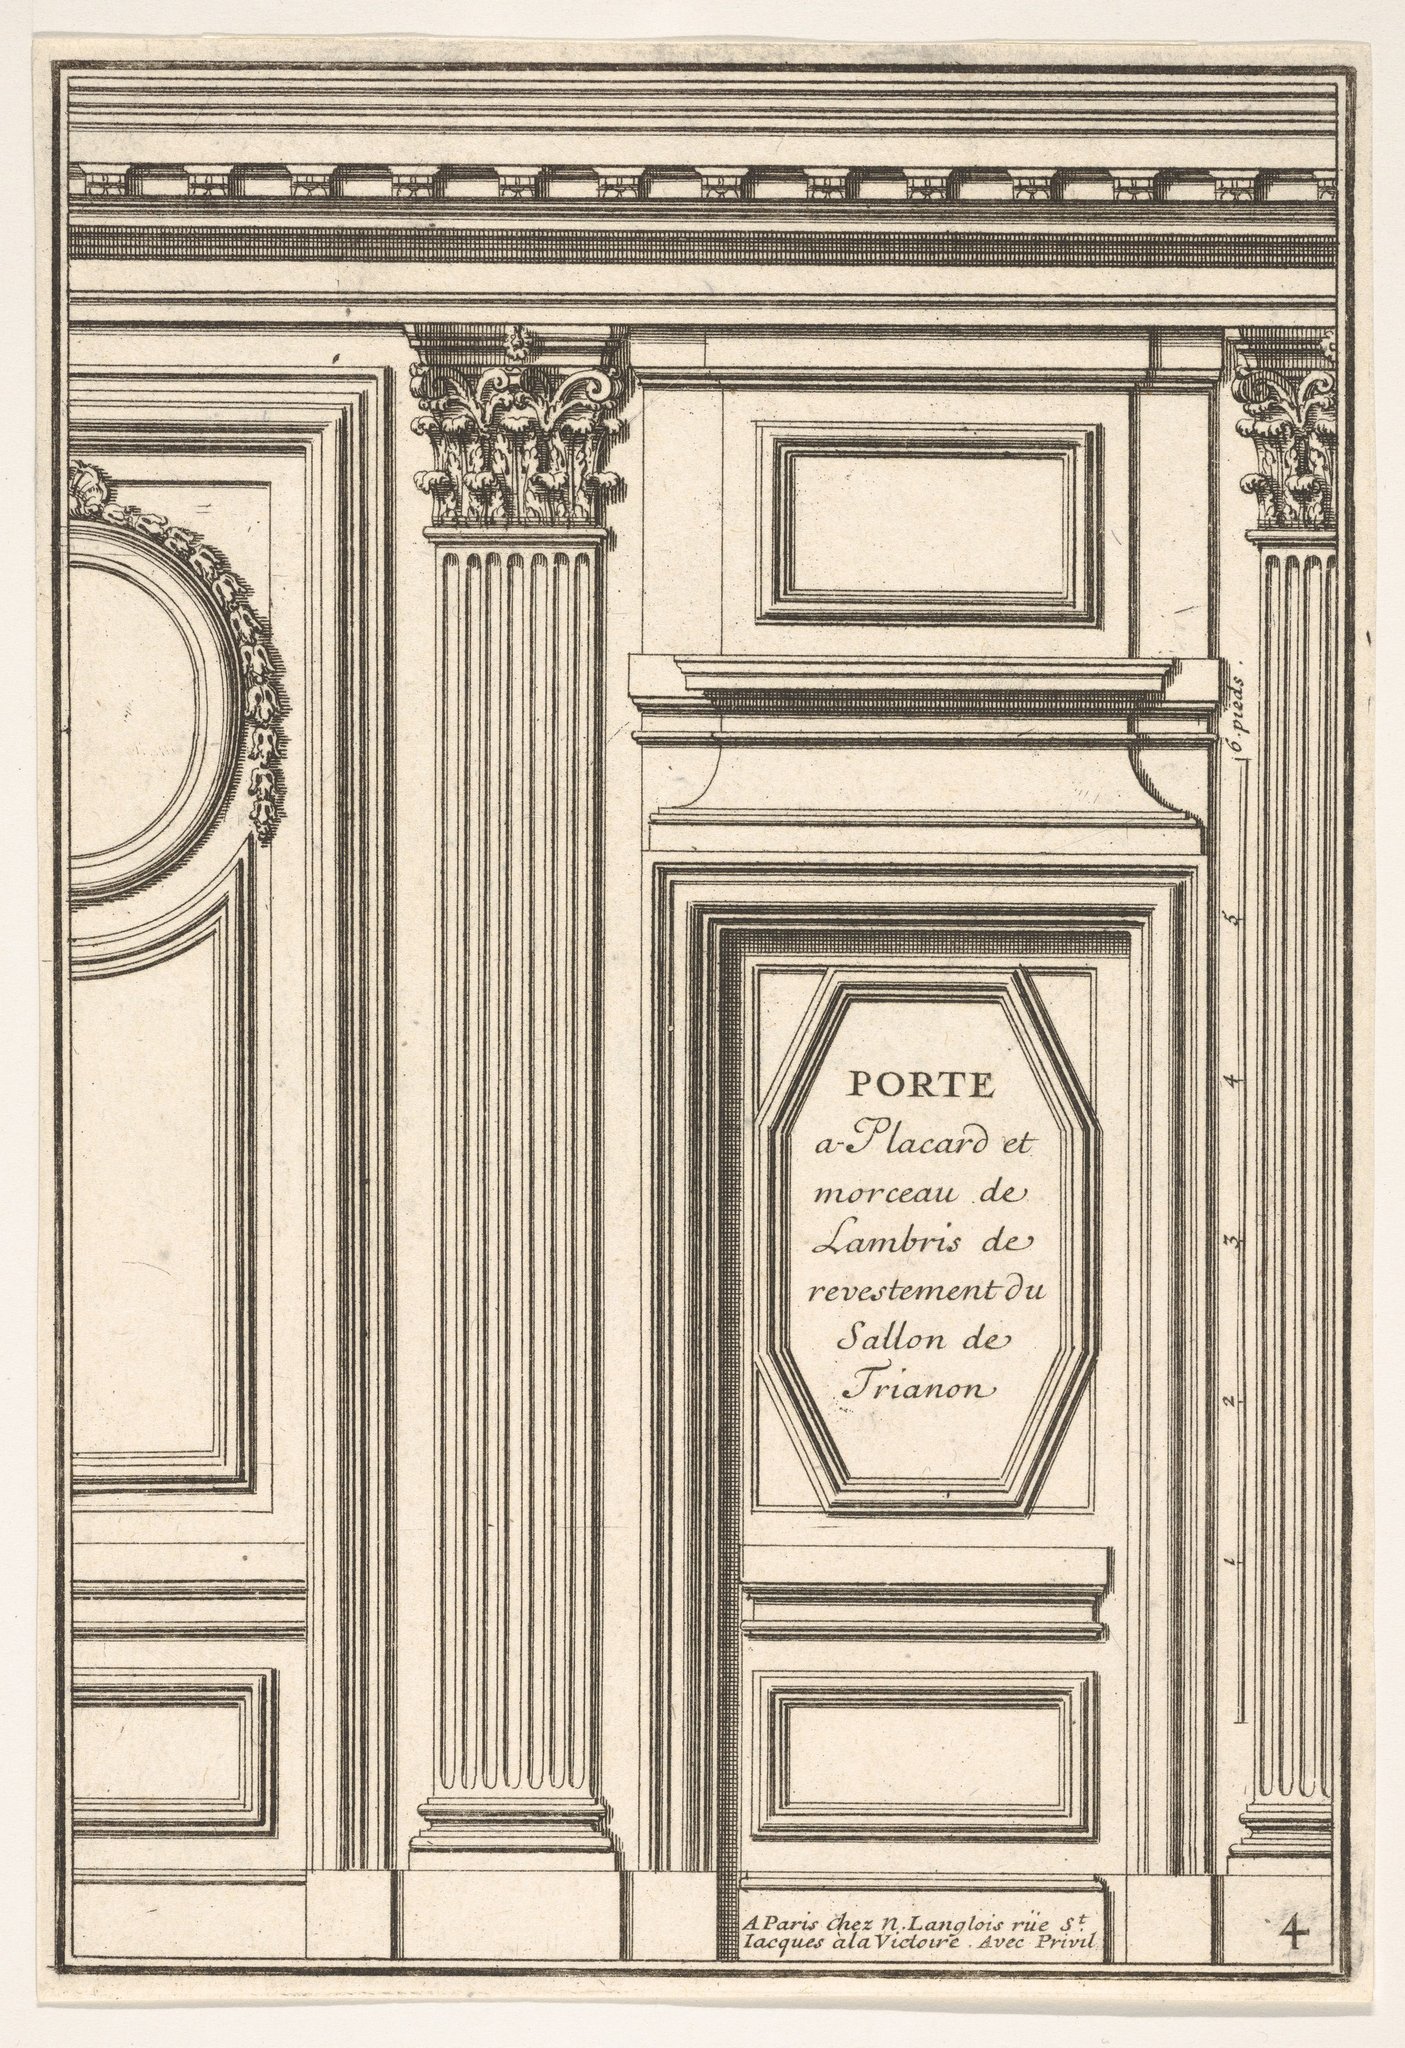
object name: print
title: Door and Part of the Wainscot in the restored Salon of the Trianon Palace, plate IV from "Portes a Placard et Lambris"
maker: jean le pautre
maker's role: etcher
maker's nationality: french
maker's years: 1618-1682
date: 1601-1700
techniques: etching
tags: architecture